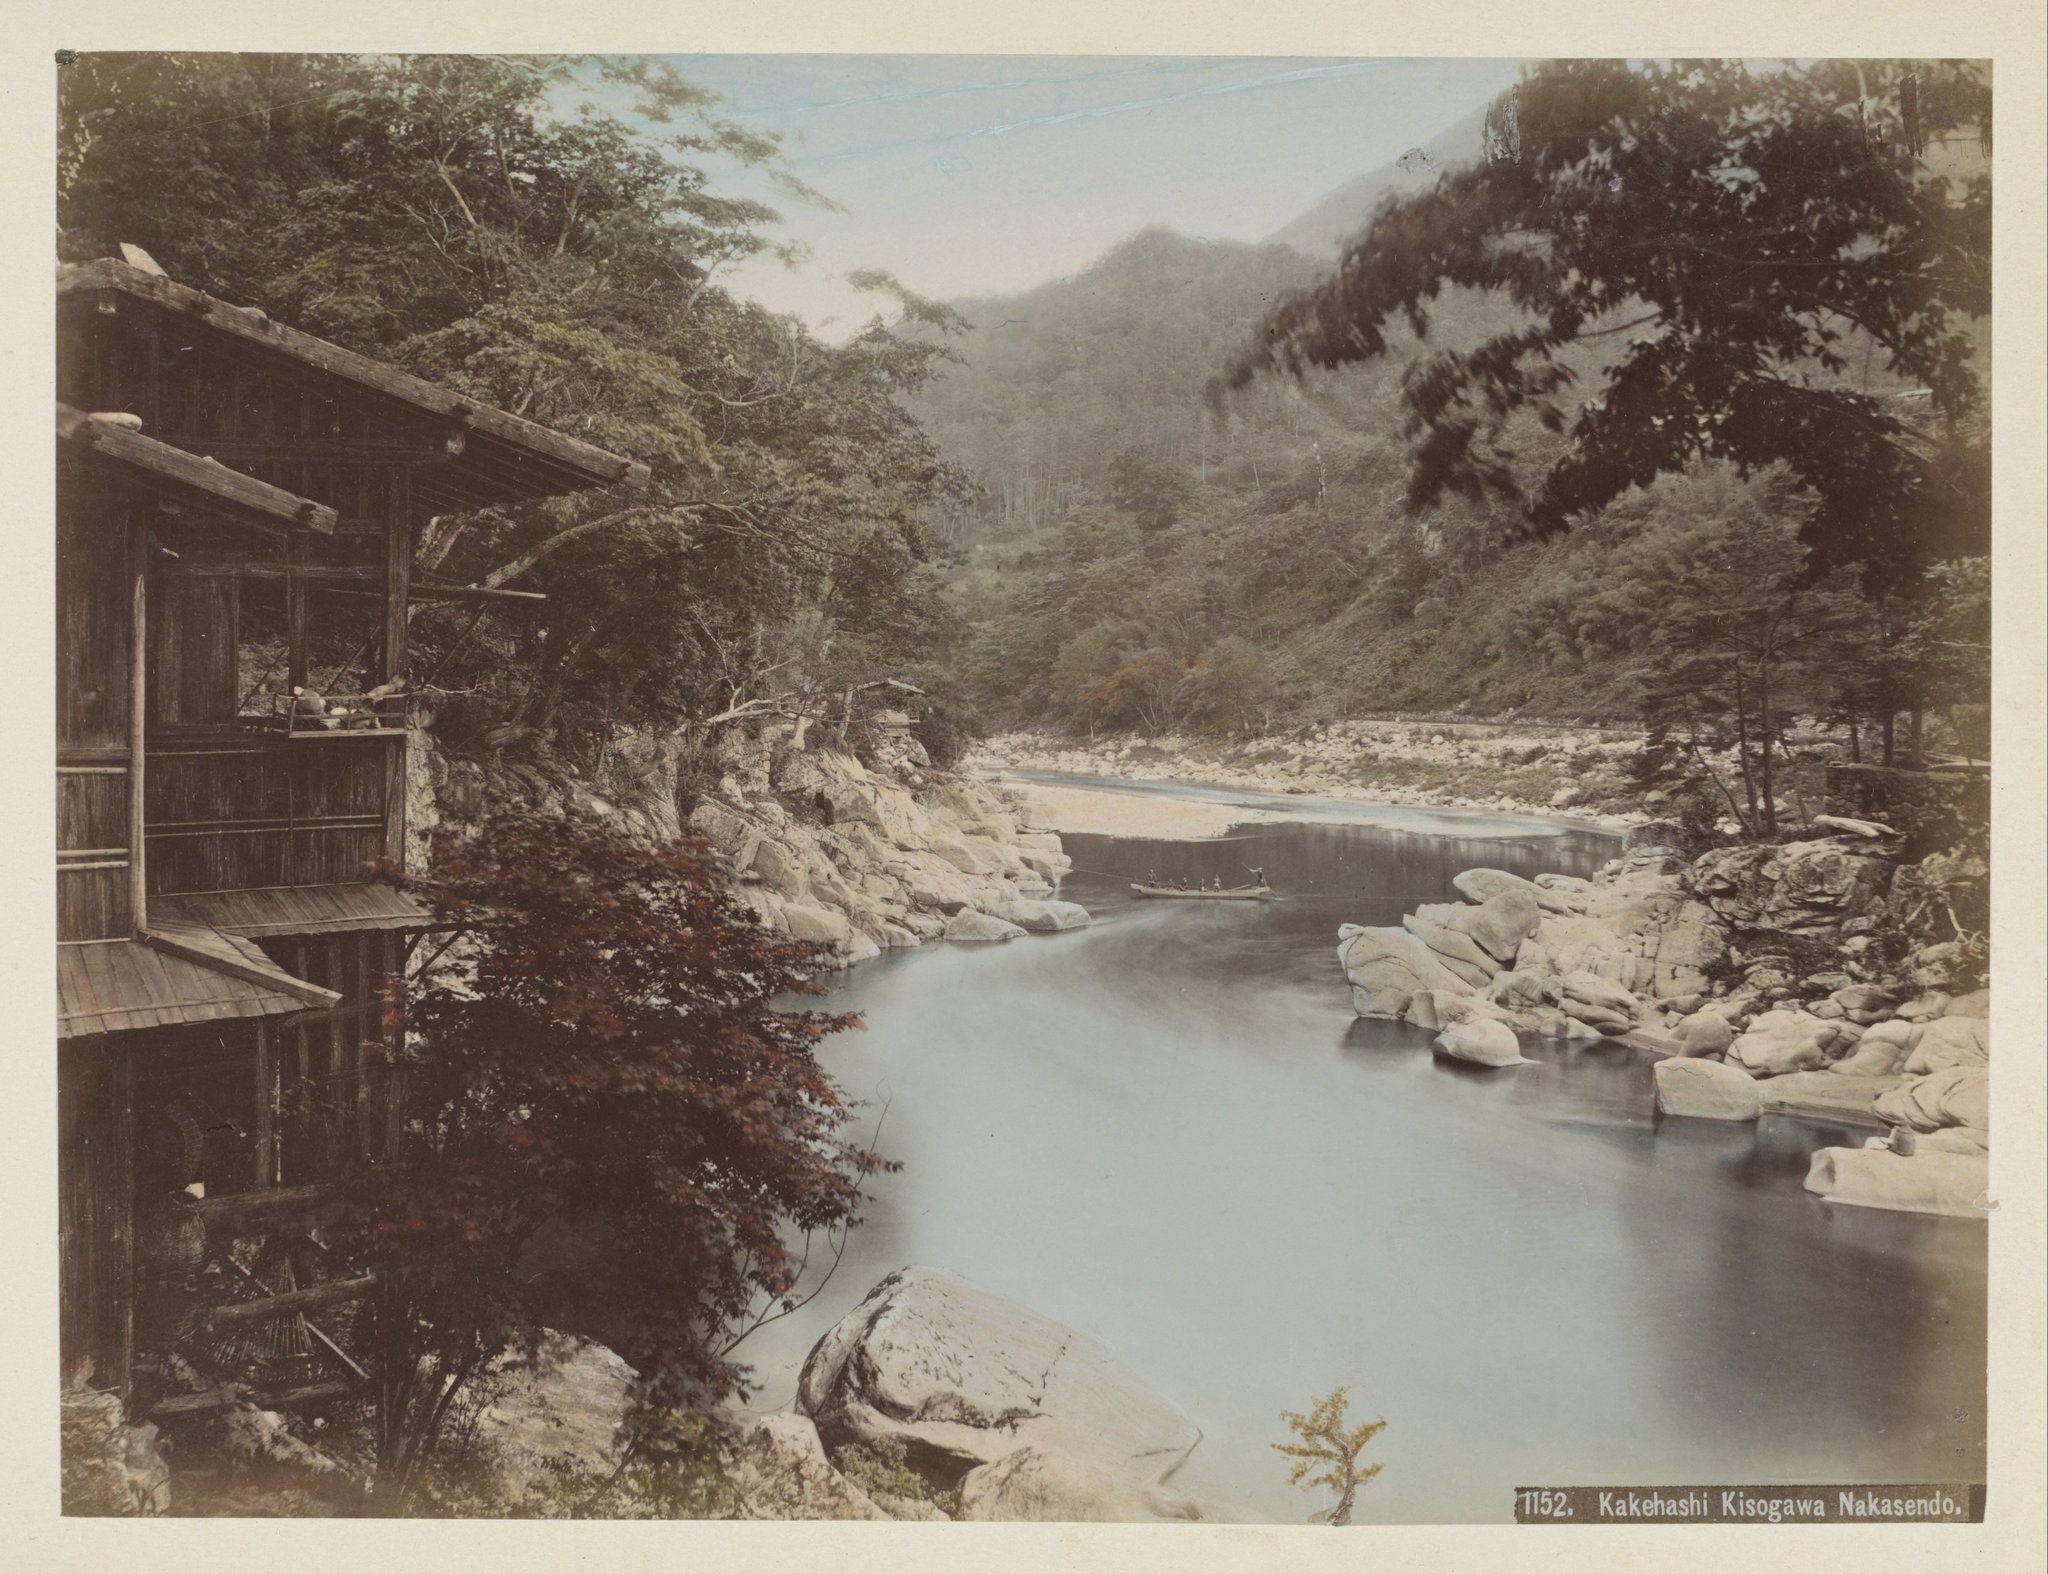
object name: photograph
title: Kakehashi Kisogawa Nakasendo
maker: Anonymous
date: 1870-1900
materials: paper, photographic support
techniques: albumen print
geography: japan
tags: river, river bank, ferry, travelling; tourism, boulder, stone, japan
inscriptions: negative number: ‘1152’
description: Onderdeel van Fotoalbum met 50 foto's van bezienswaardigheden in Japan.